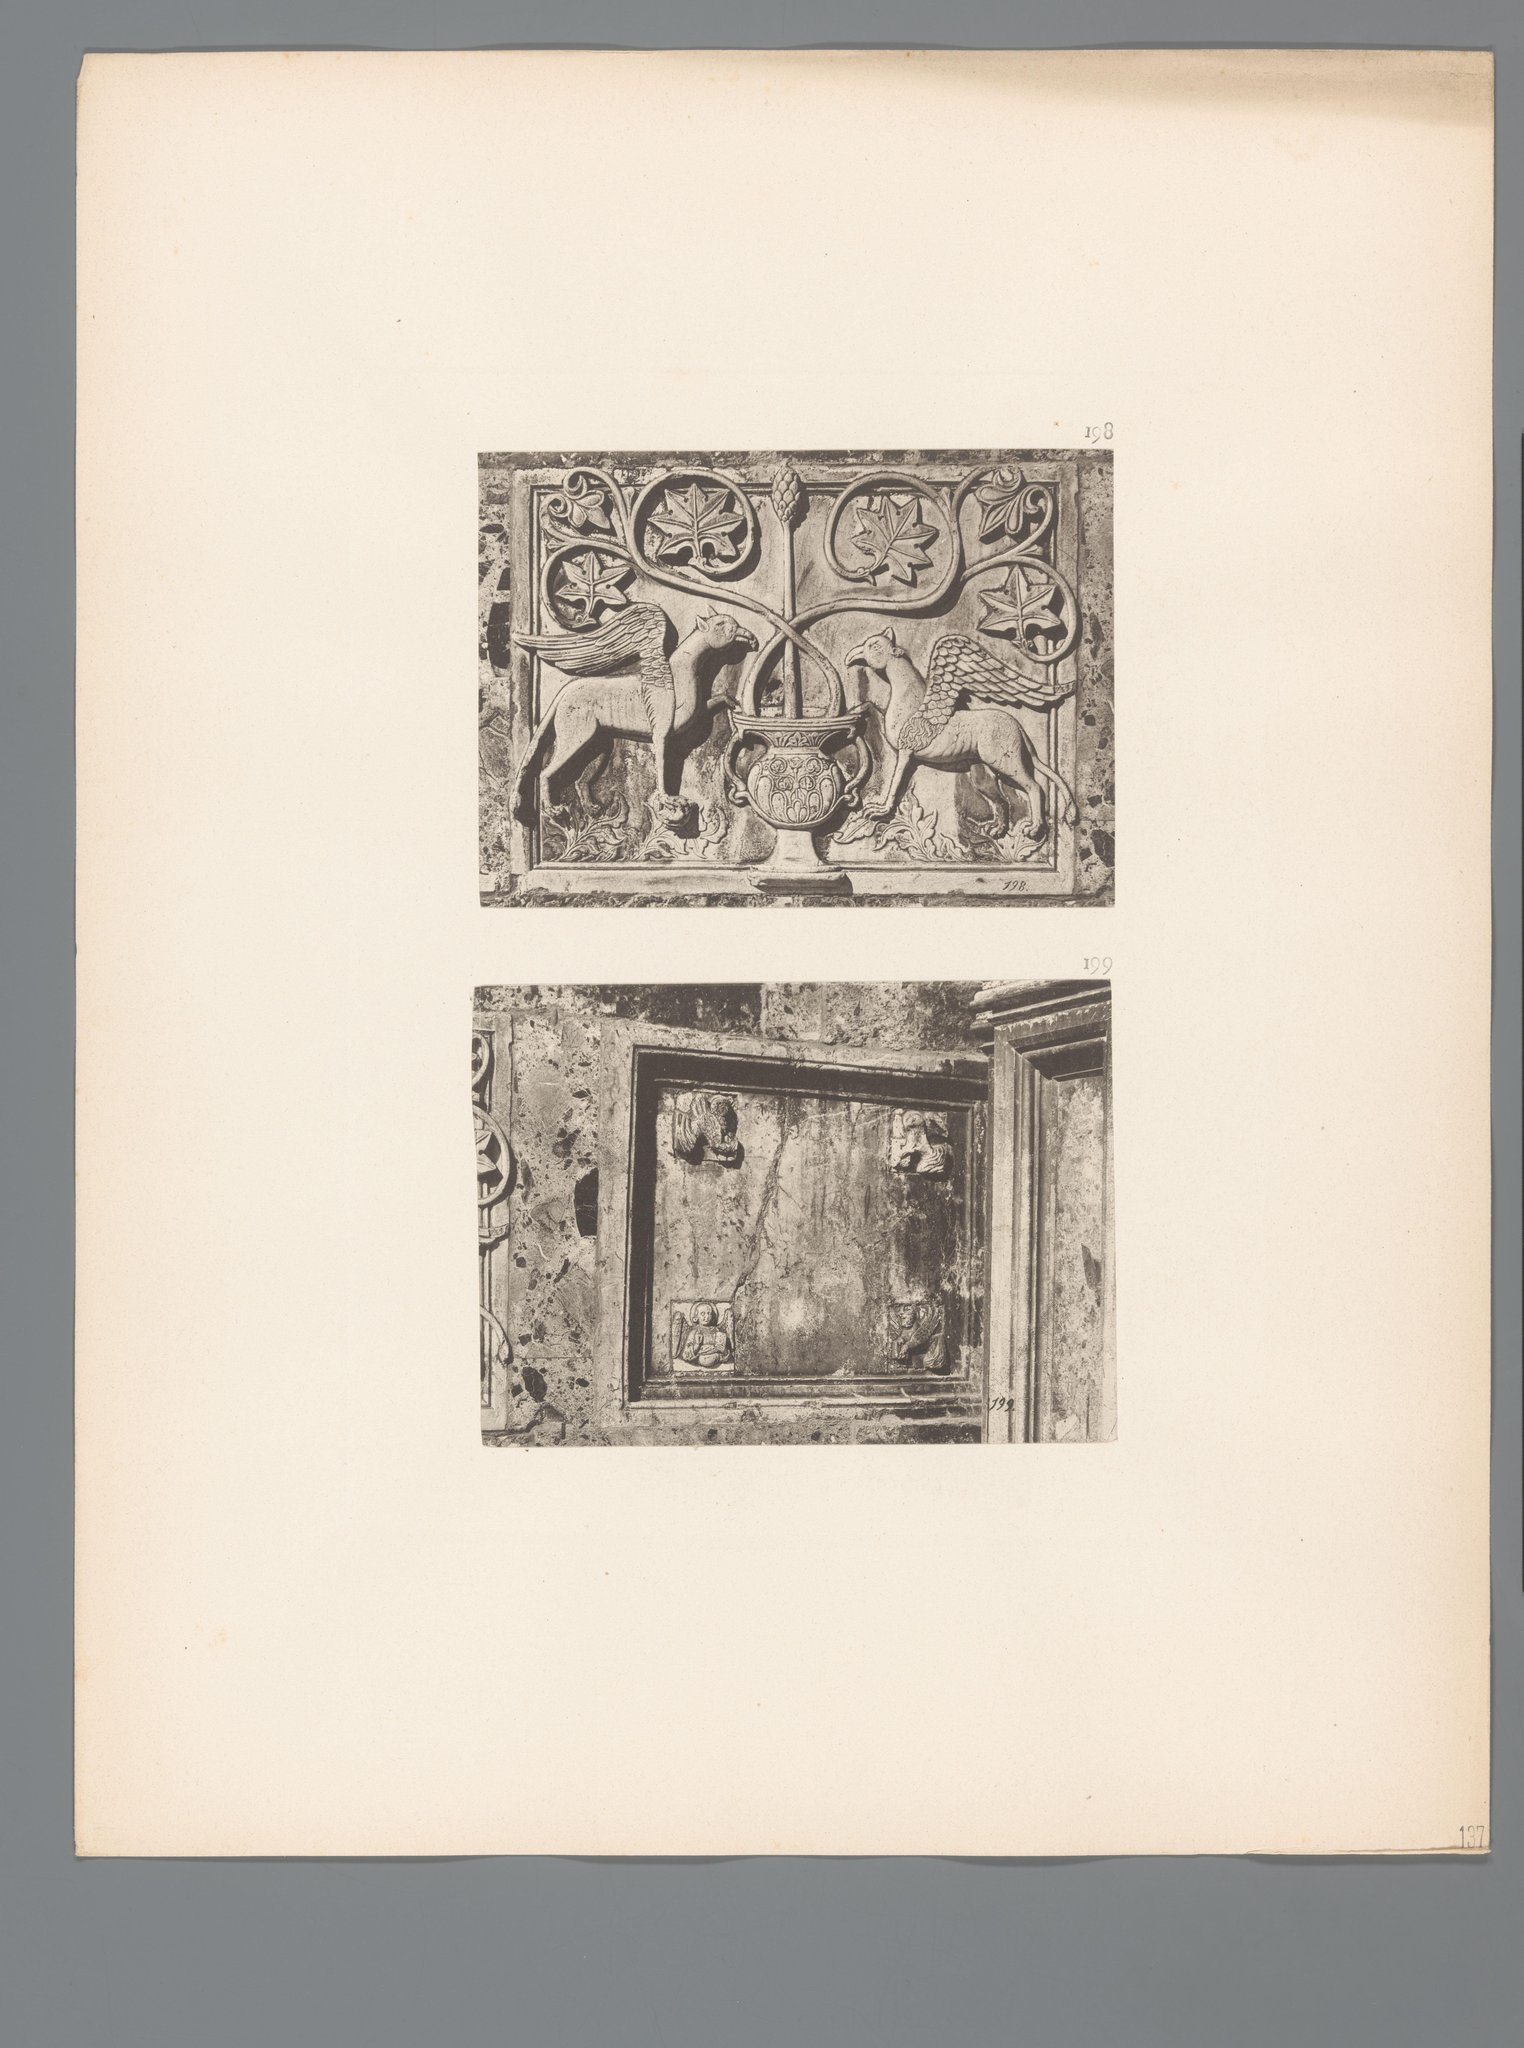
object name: photomechanical print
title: Twee details van het exterieur van de San Marco in Venetië, waarvan één met griffioenen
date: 1879-1884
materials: paper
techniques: photograph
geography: venice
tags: griffin (lion/eagle); 'griffo' (ripa), church (exterior), piece of sculpture, reproduction of a piece of sculpture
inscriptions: number: ‘137’, number: ‘198’, number: ‘199’, number: ‘199.’, number: ‘198.’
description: Deze prenten maken deel uit van een omslag met 51 prenten op 29 bladen en 1 tekstblad.